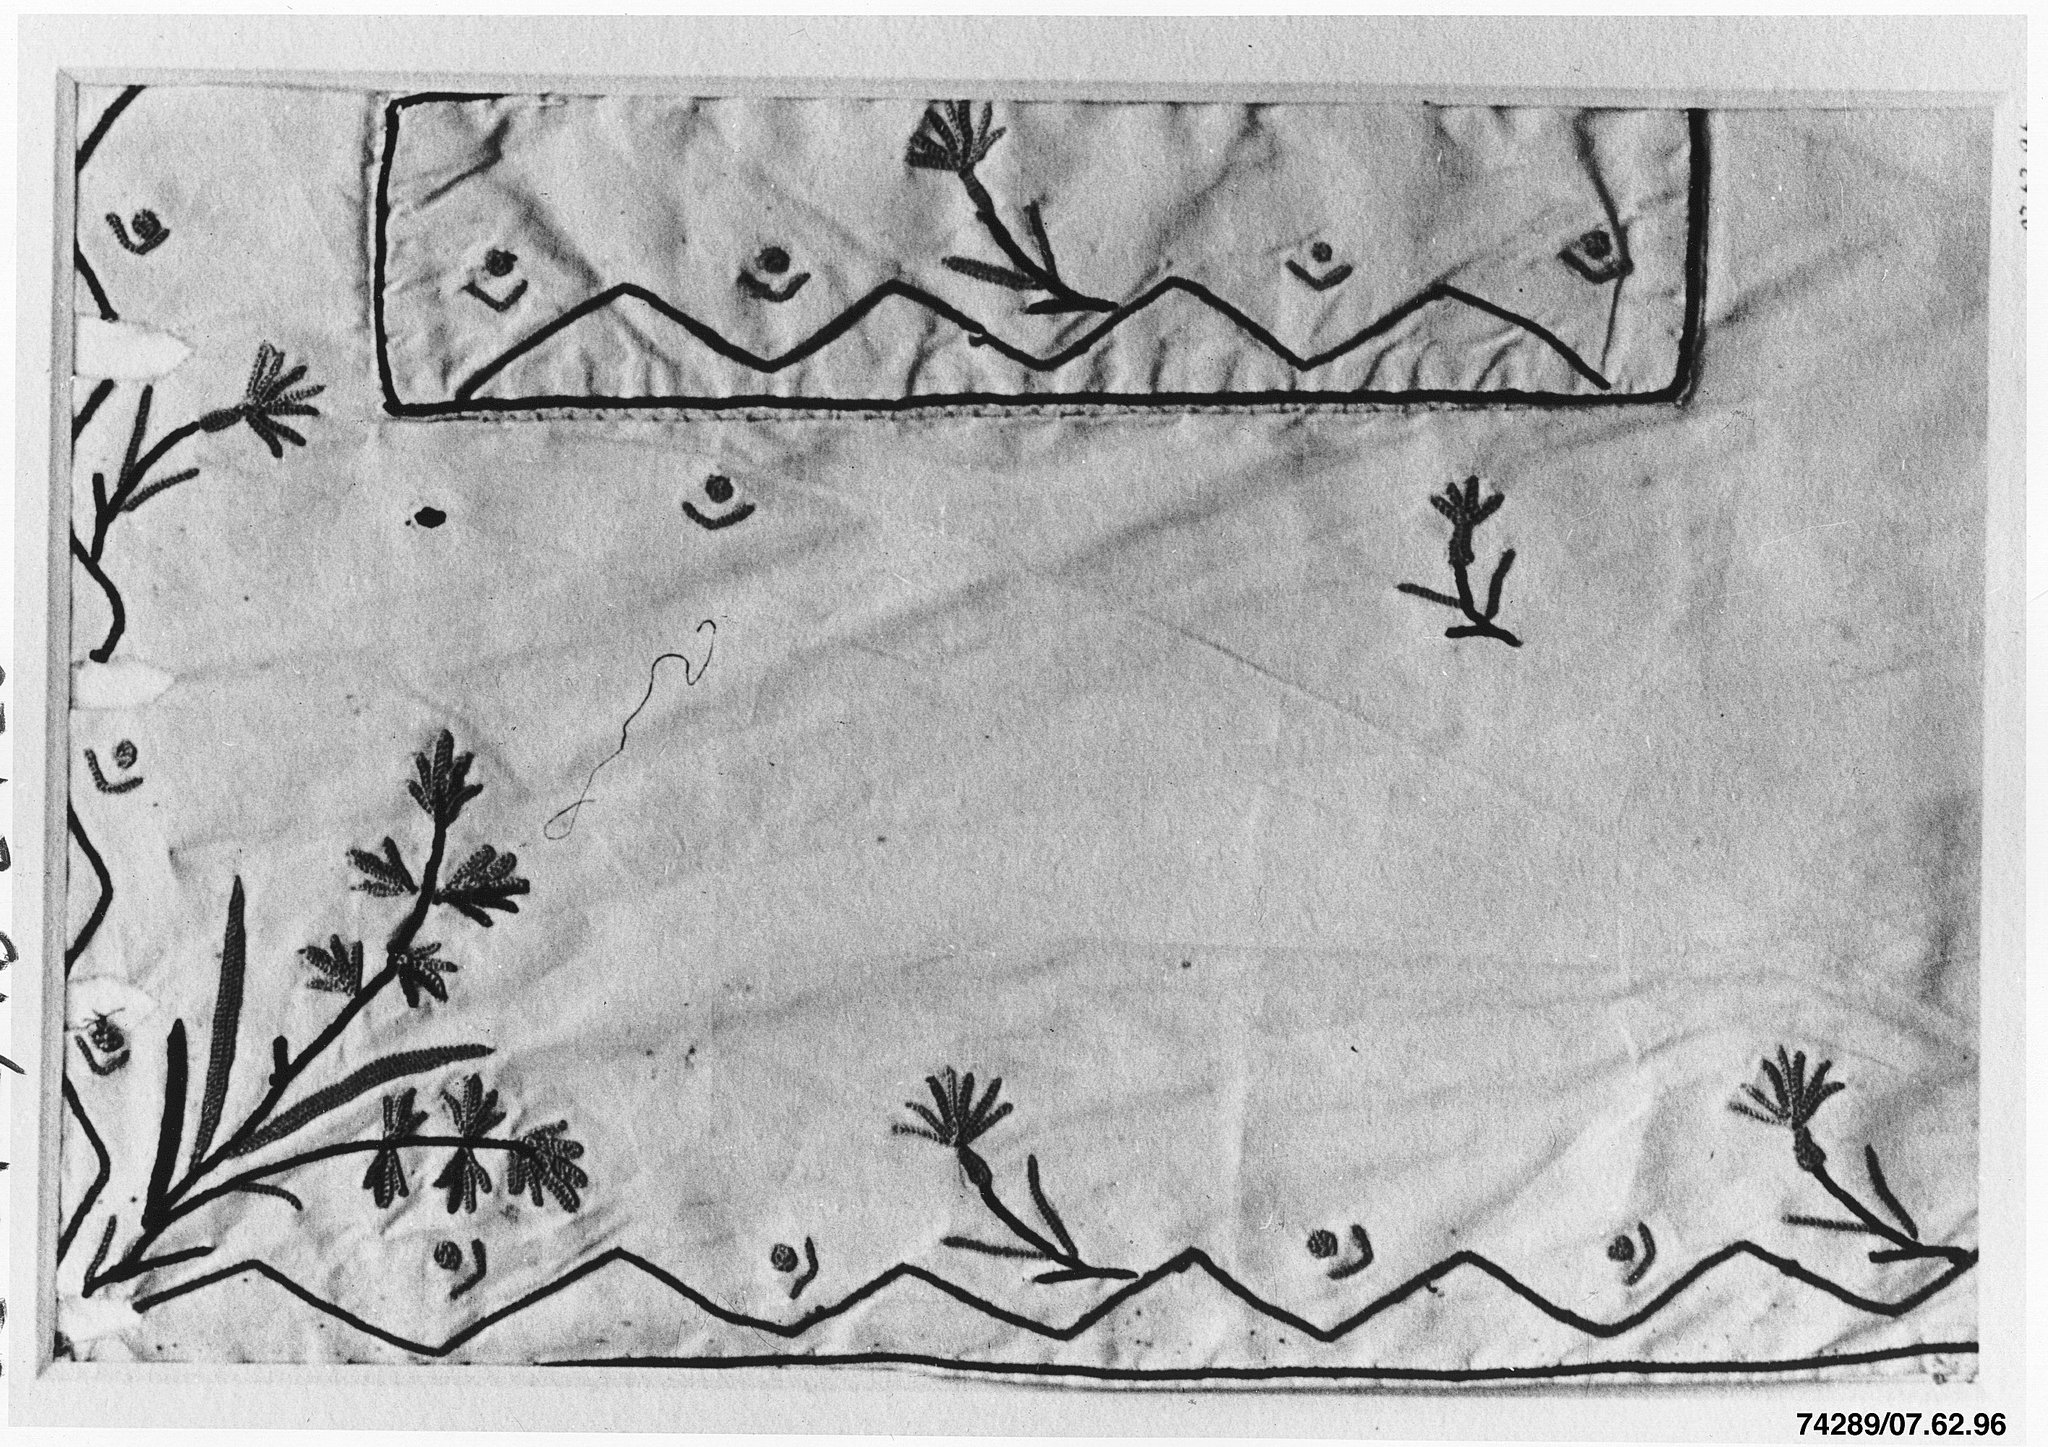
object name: fragment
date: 1701-1800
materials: silk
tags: flowers,leaves